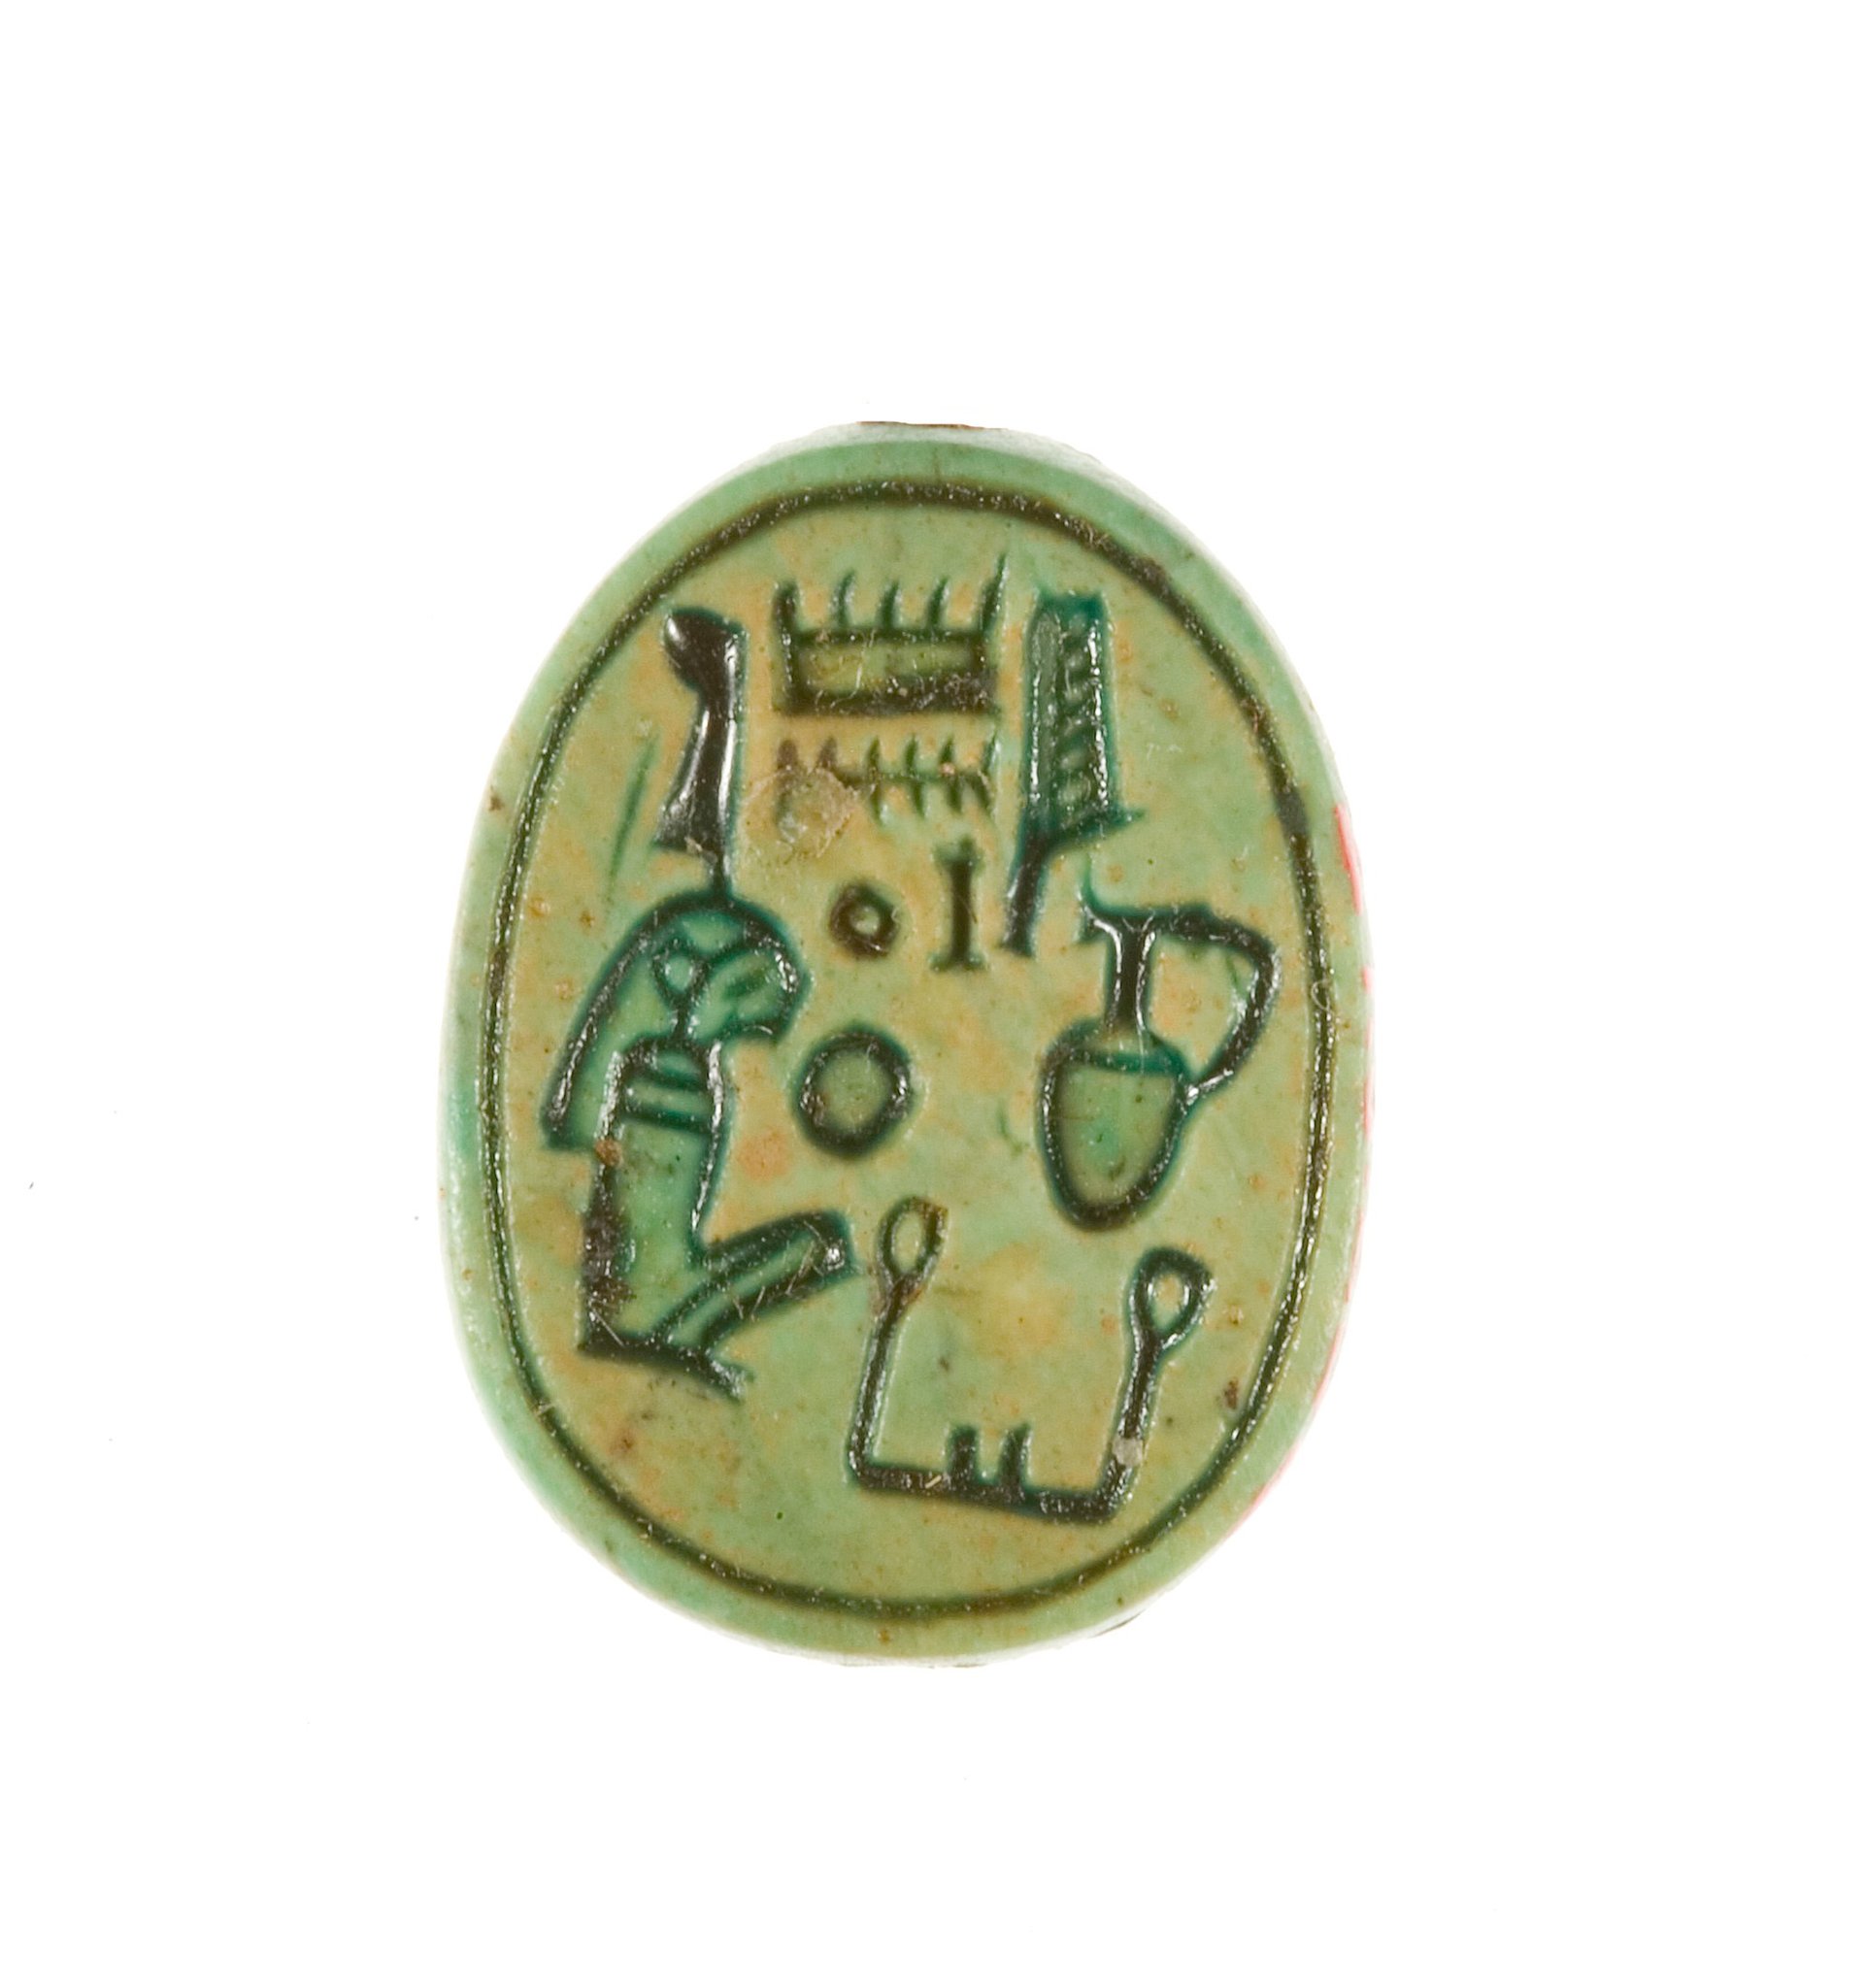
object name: scarab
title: Scarab for Maatkare (Hatshepsut), United with Amun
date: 1479-1458 BCE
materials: stone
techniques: glazing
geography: egypt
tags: hieroglyphs,scarabs